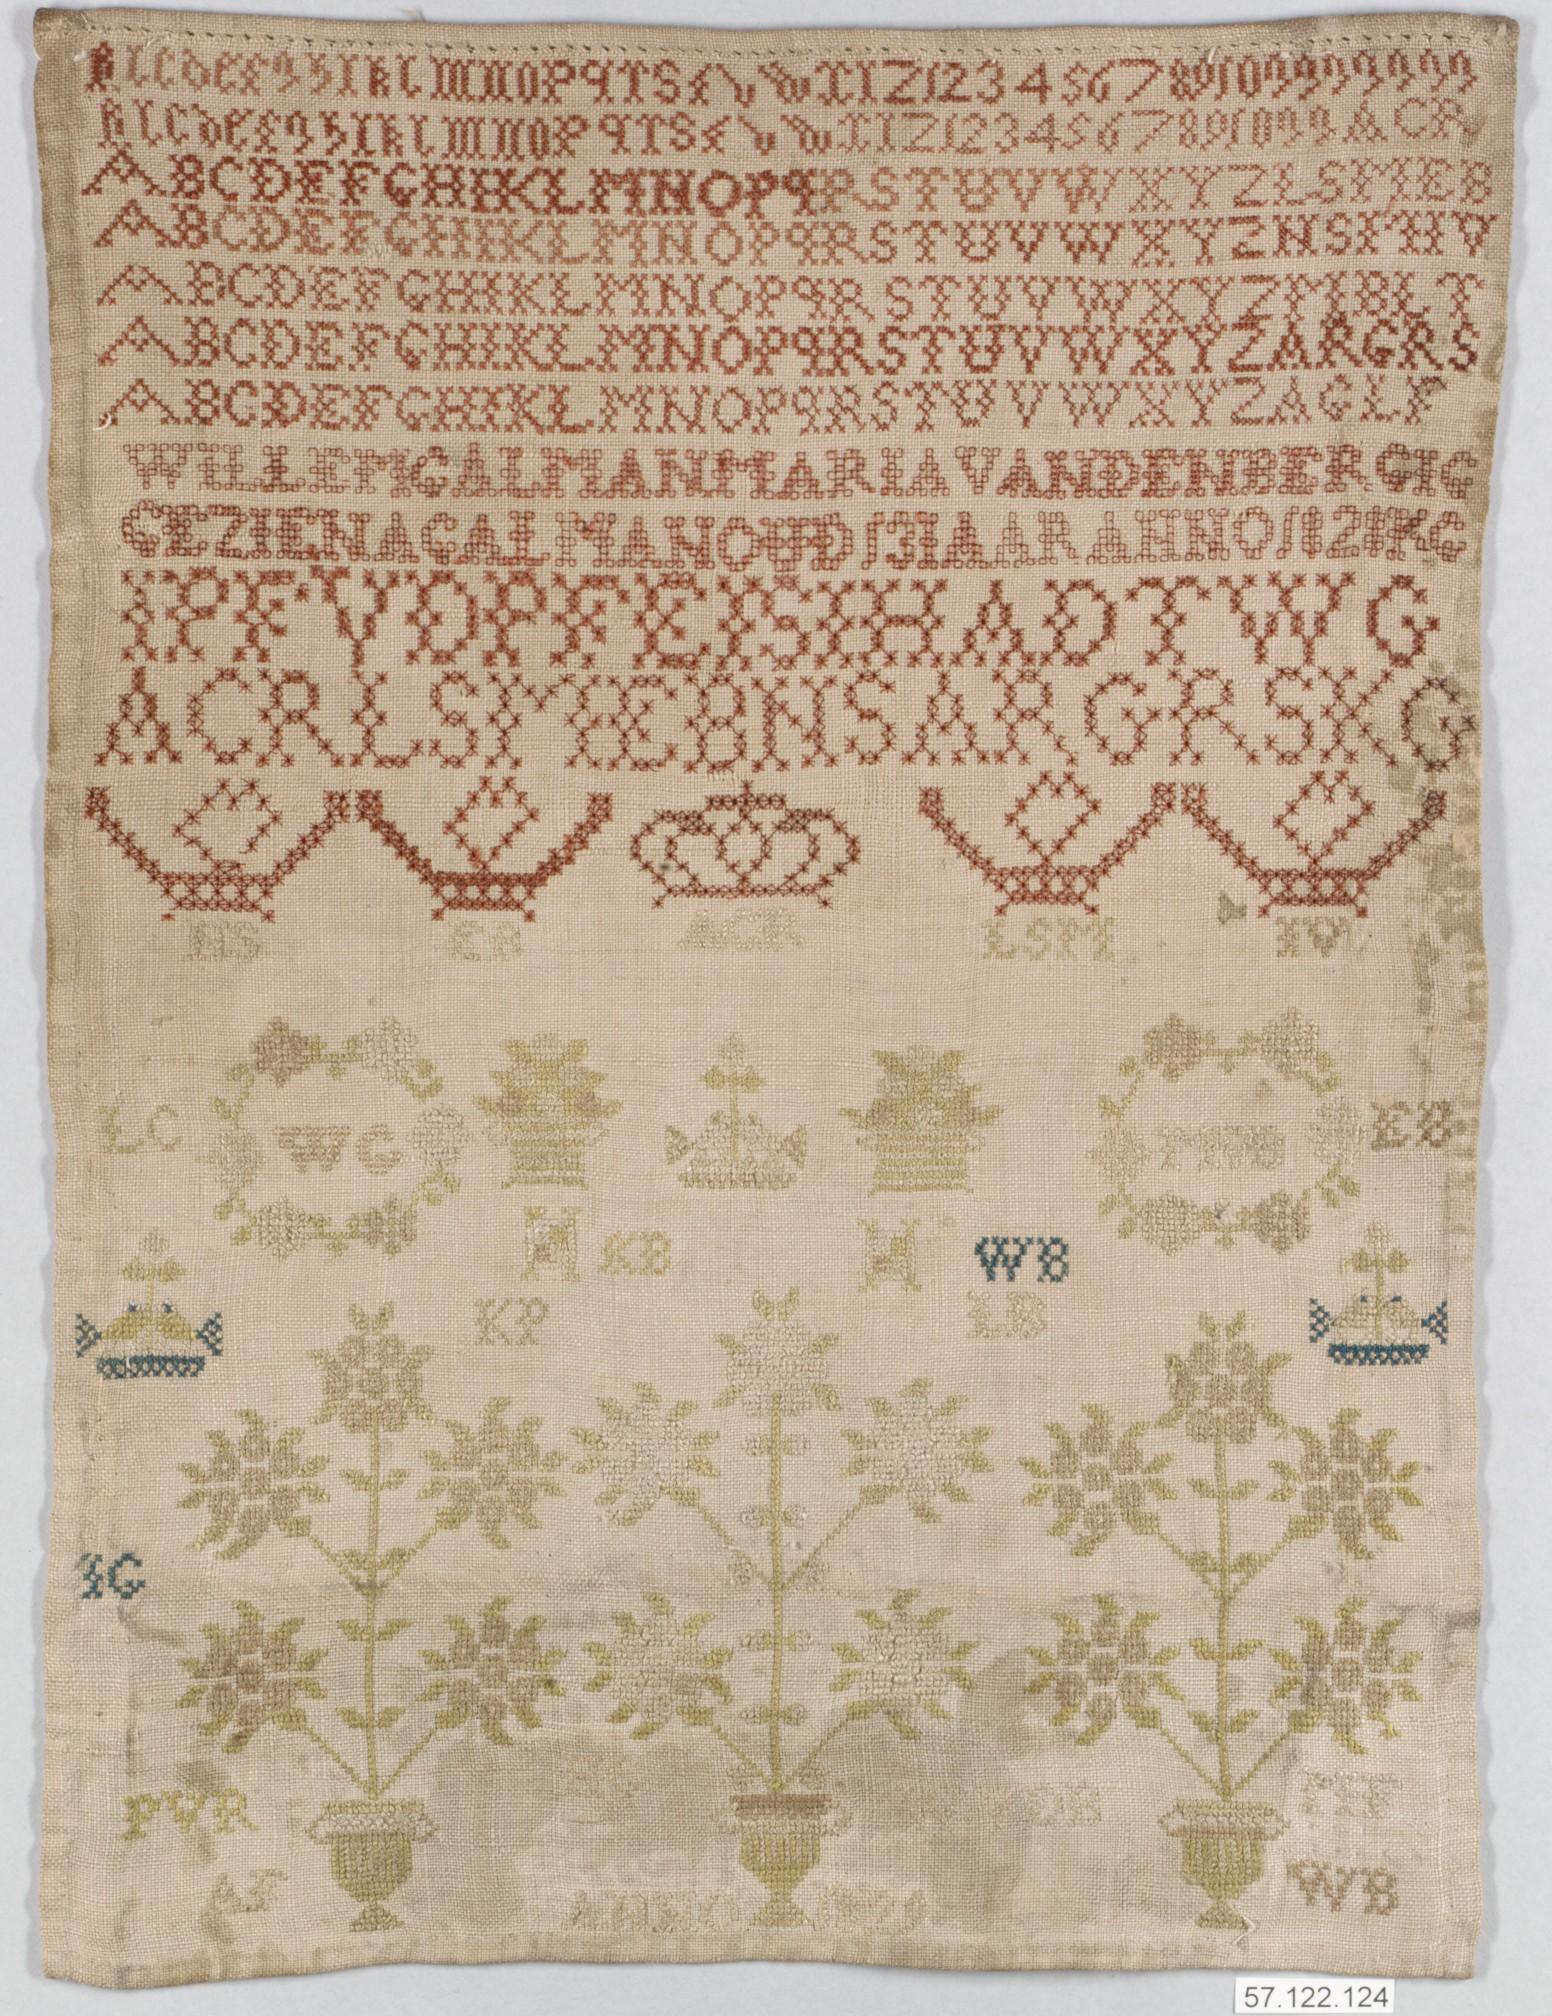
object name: sampler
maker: gesina hendrica galman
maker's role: artist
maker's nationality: dutch, born ca. 1815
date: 1829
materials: linen, silk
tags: flowers